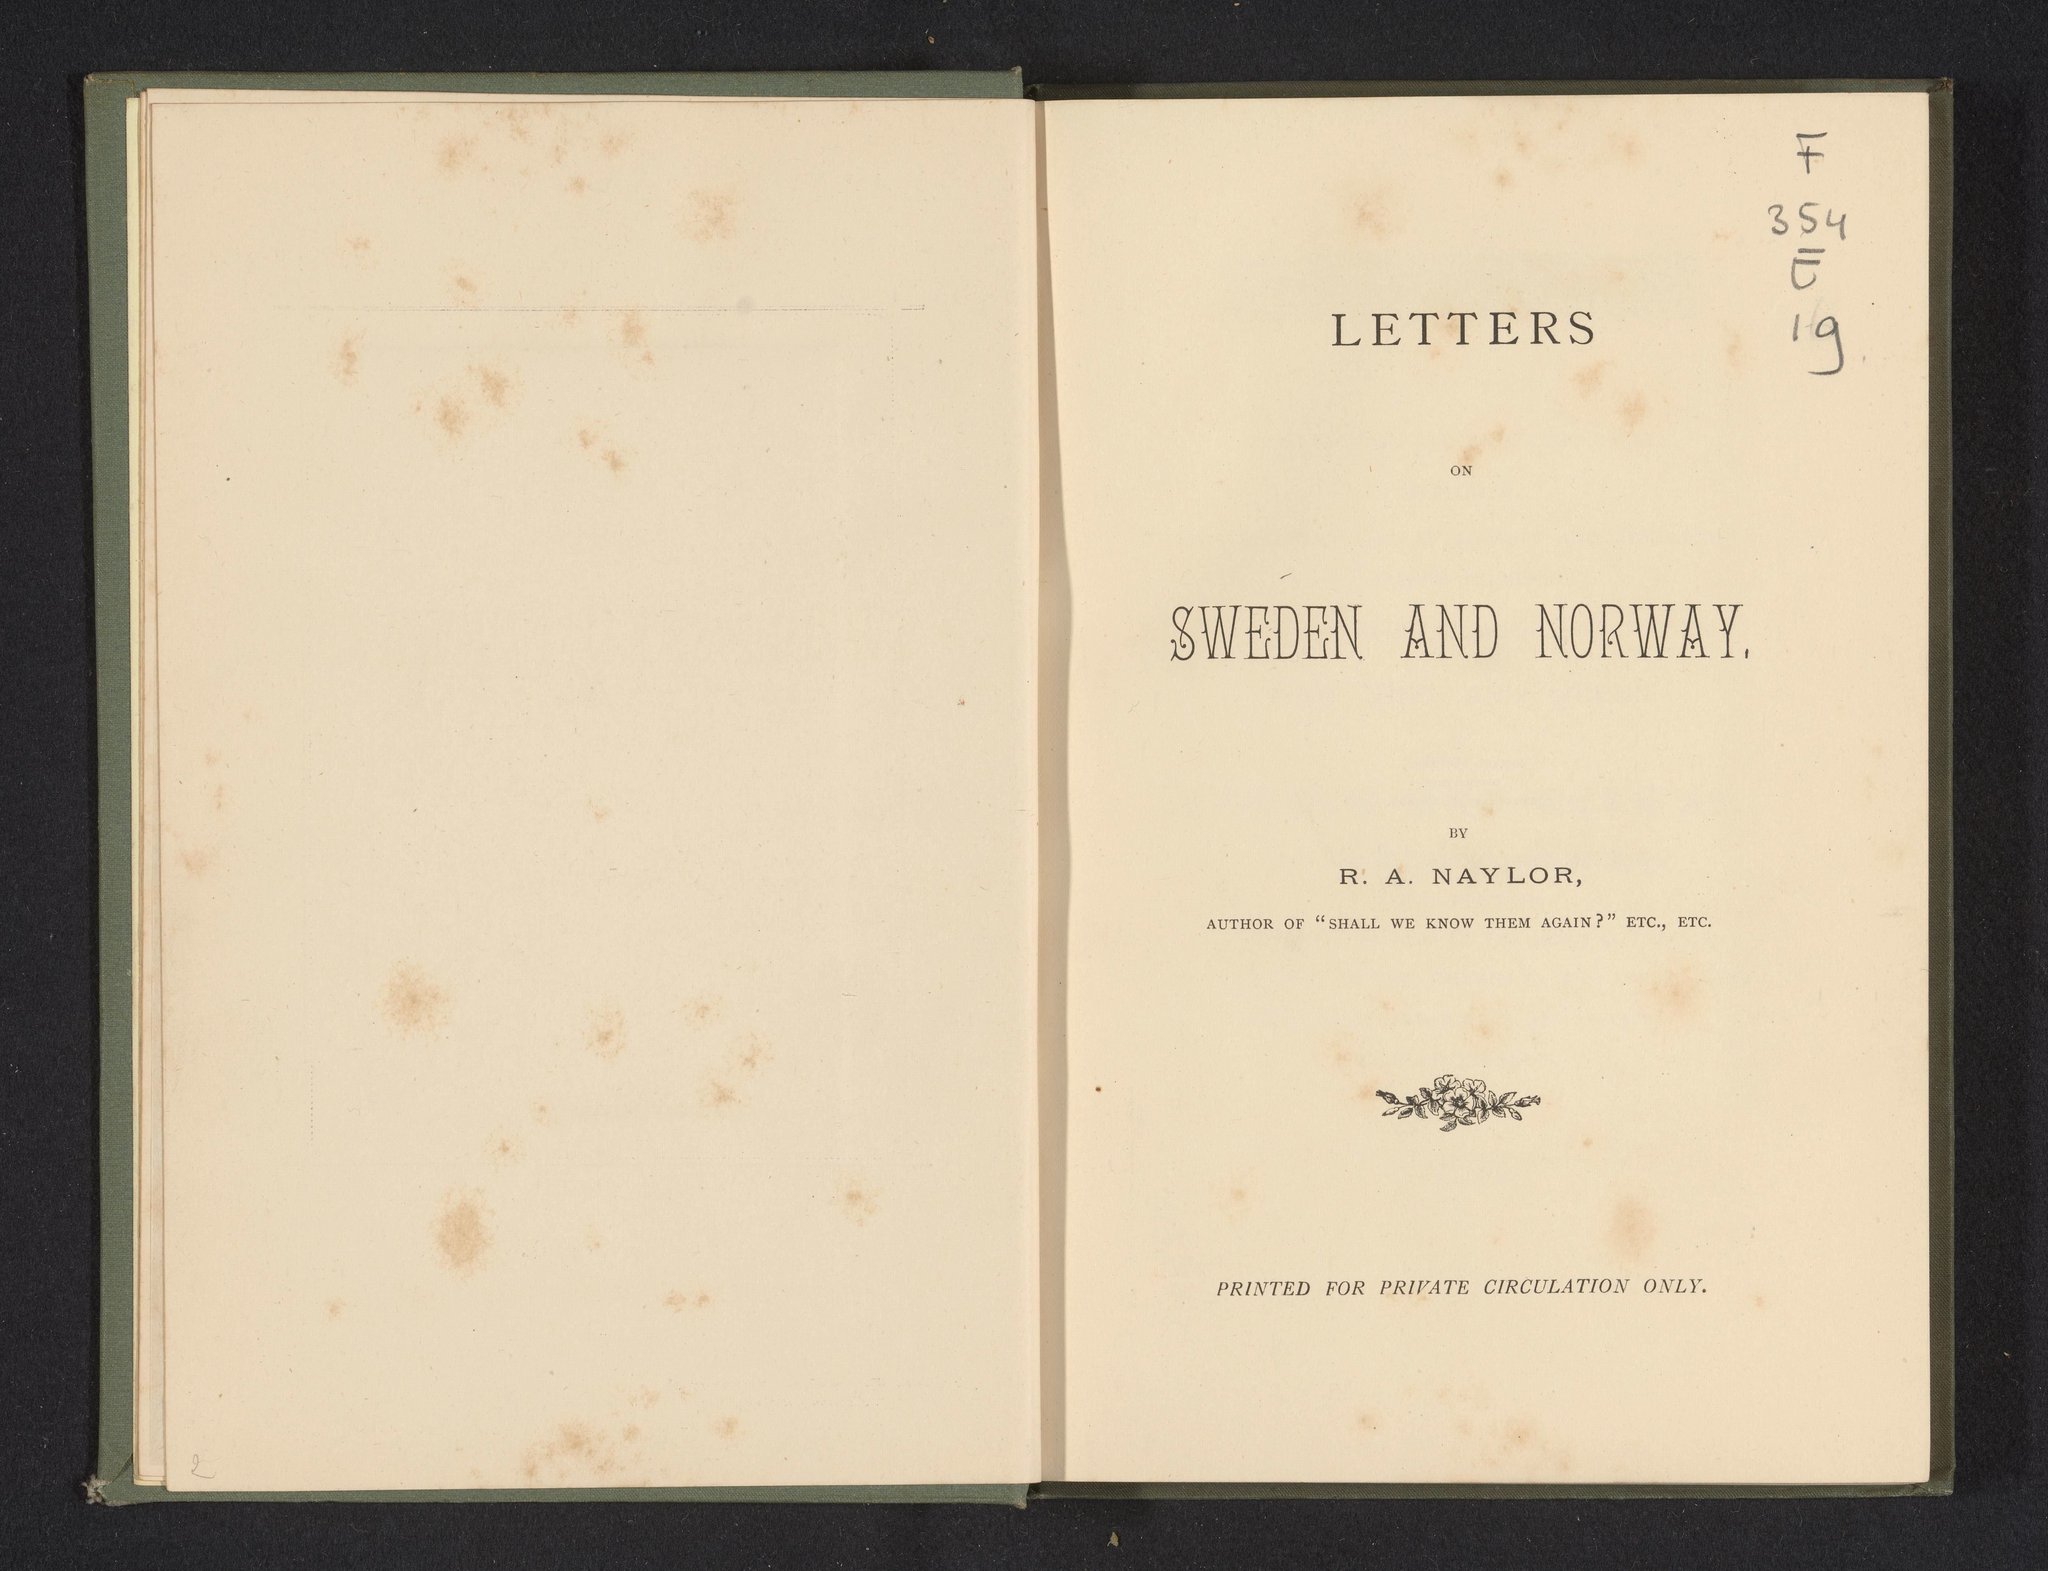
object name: book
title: Letters on Sweden and Norway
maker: robert anderson naylor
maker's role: schrijver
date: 1887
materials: cardboard, linen, paper, photographic support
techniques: albumen print, engraving, printing